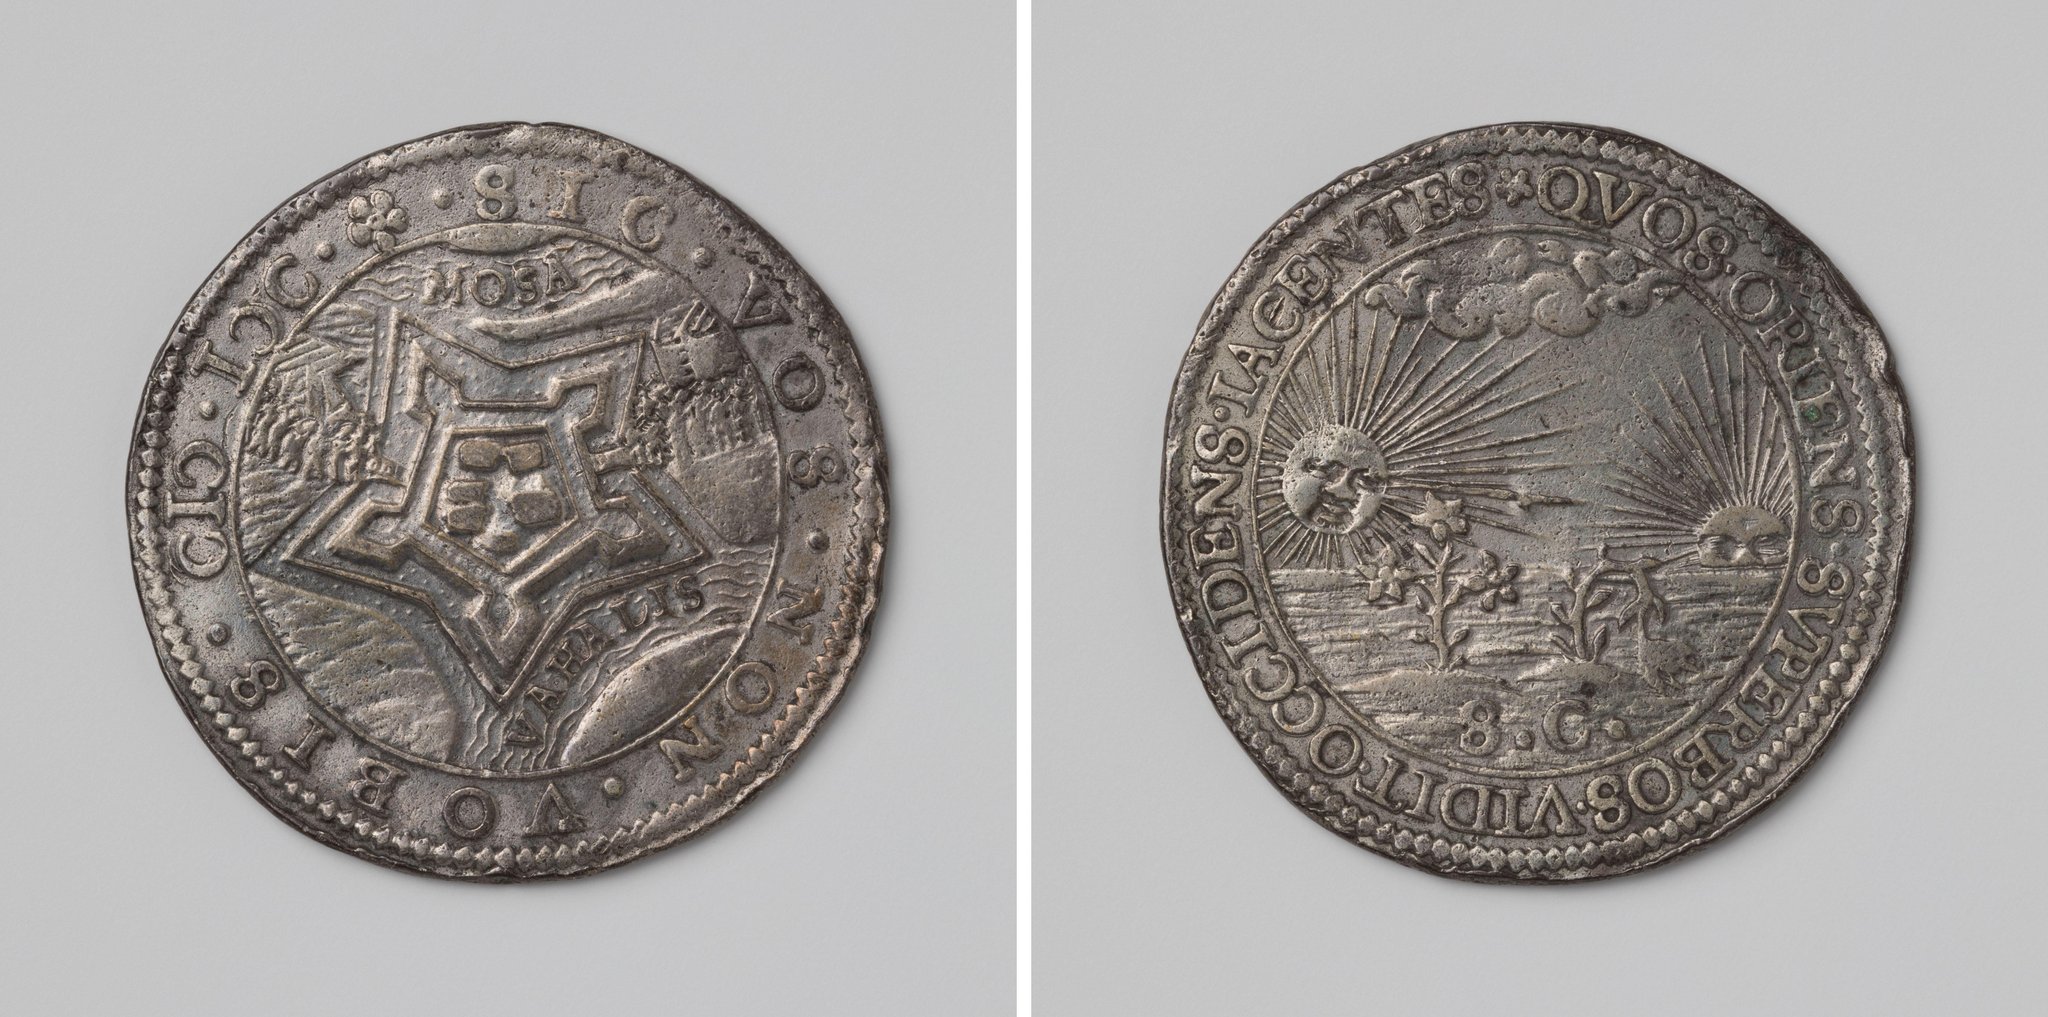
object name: jeton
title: Inname van de schans St. Andries door de troepen van Maurits, graaf van Nassau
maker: Anonymous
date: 1600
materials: silver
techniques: striking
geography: dordrecht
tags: the hague, maurice (prince of orange)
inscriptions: circumscription: ‘QVOS ORIENS SVPERBOS VIDIT OCCIDENS IACENTES / S C’, circumscription: ‘SIC VOS NON VOBIS MDC’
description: Zilveren penning. Voorzijde: plattegrond van de schans tussen rivieren Maas en Waal binnen omschrift. Keerzijde: links: bloem, die zich bij zonsopkomst opricht; rechts: bloem, die bij zonsondergang verwelkt boven letters S.C. binnen omschrift.